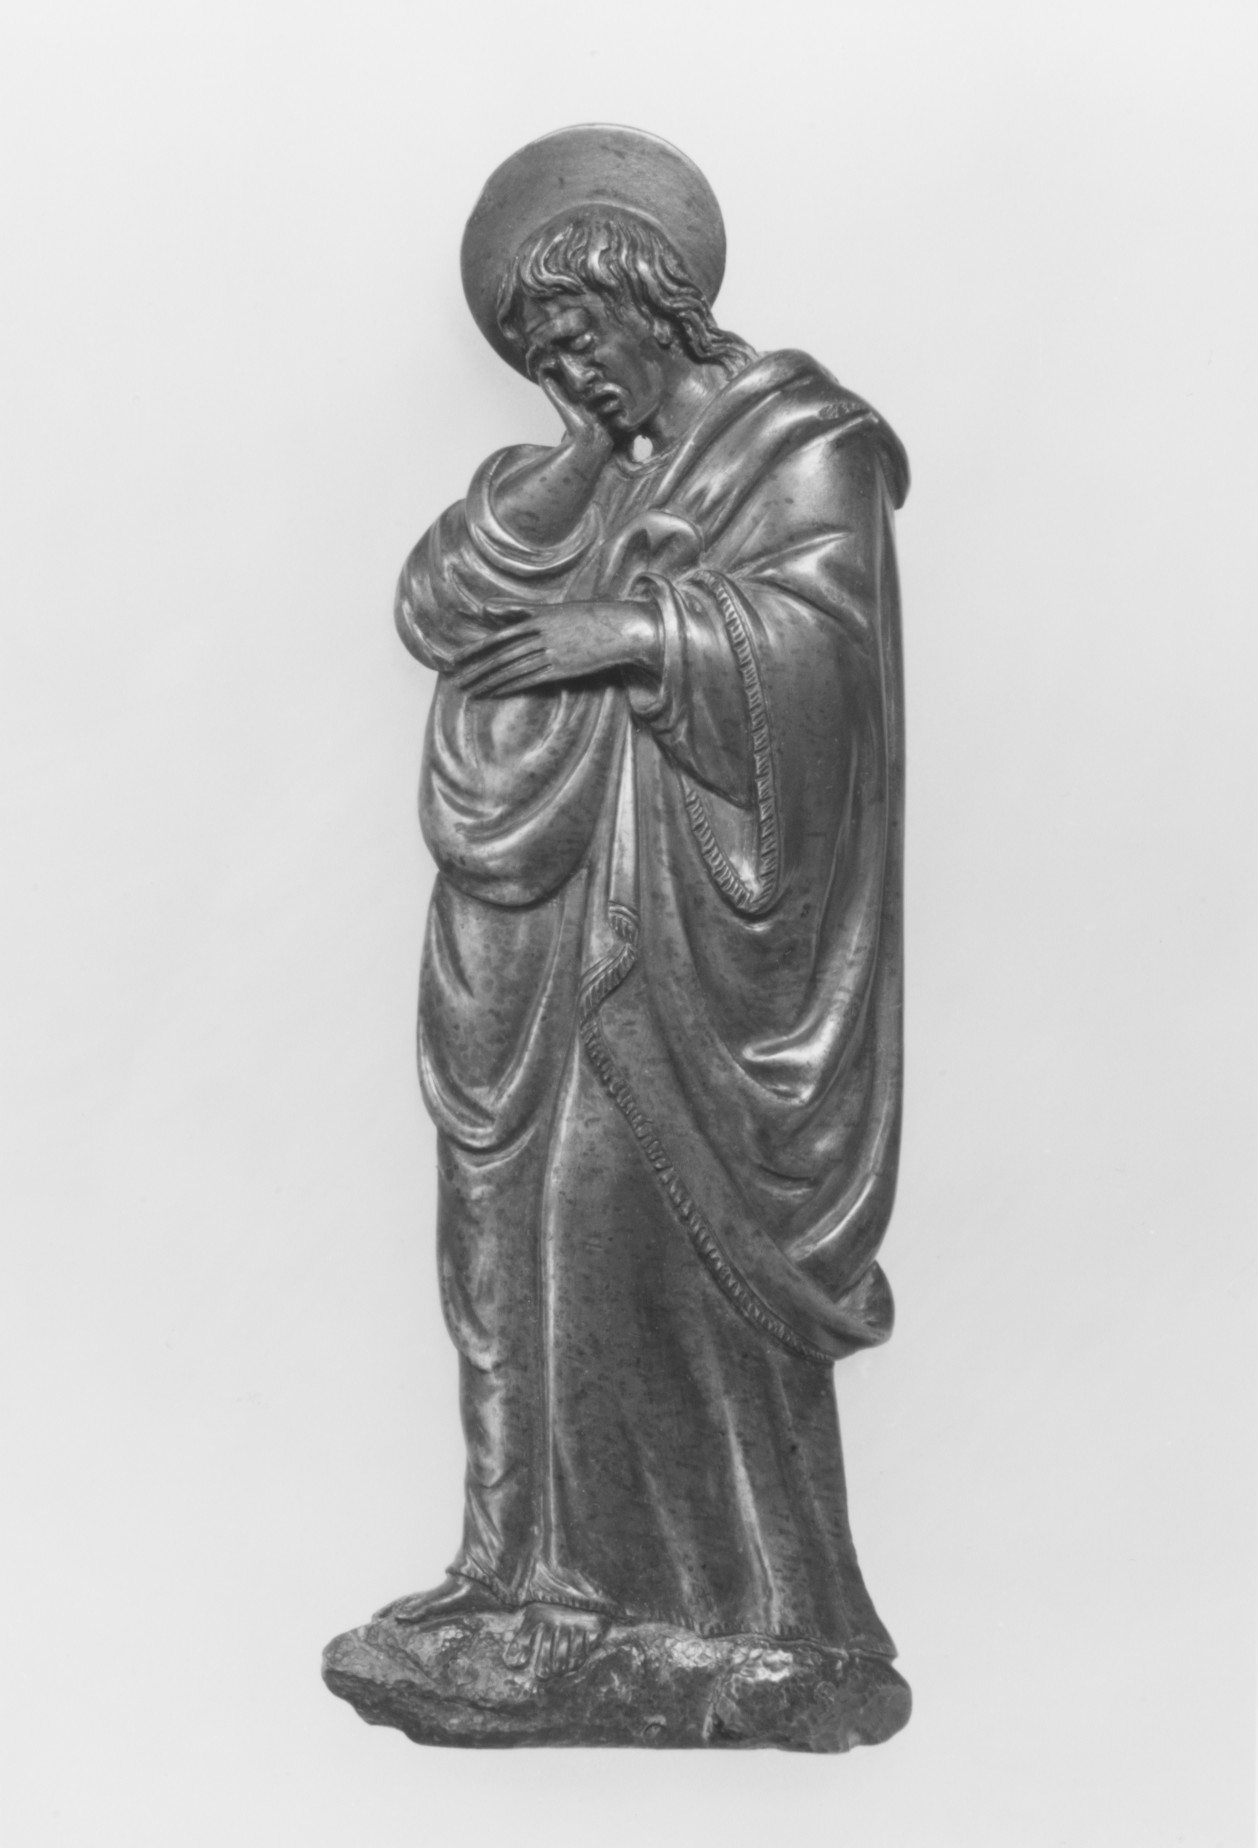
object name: relief figure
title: Mourning St. John from a Crucifixion Group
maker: benedetto da maiano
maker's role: designer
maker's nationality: italian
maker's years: 1442-1497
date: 1401-1500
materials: bronze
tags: saint john the baptist